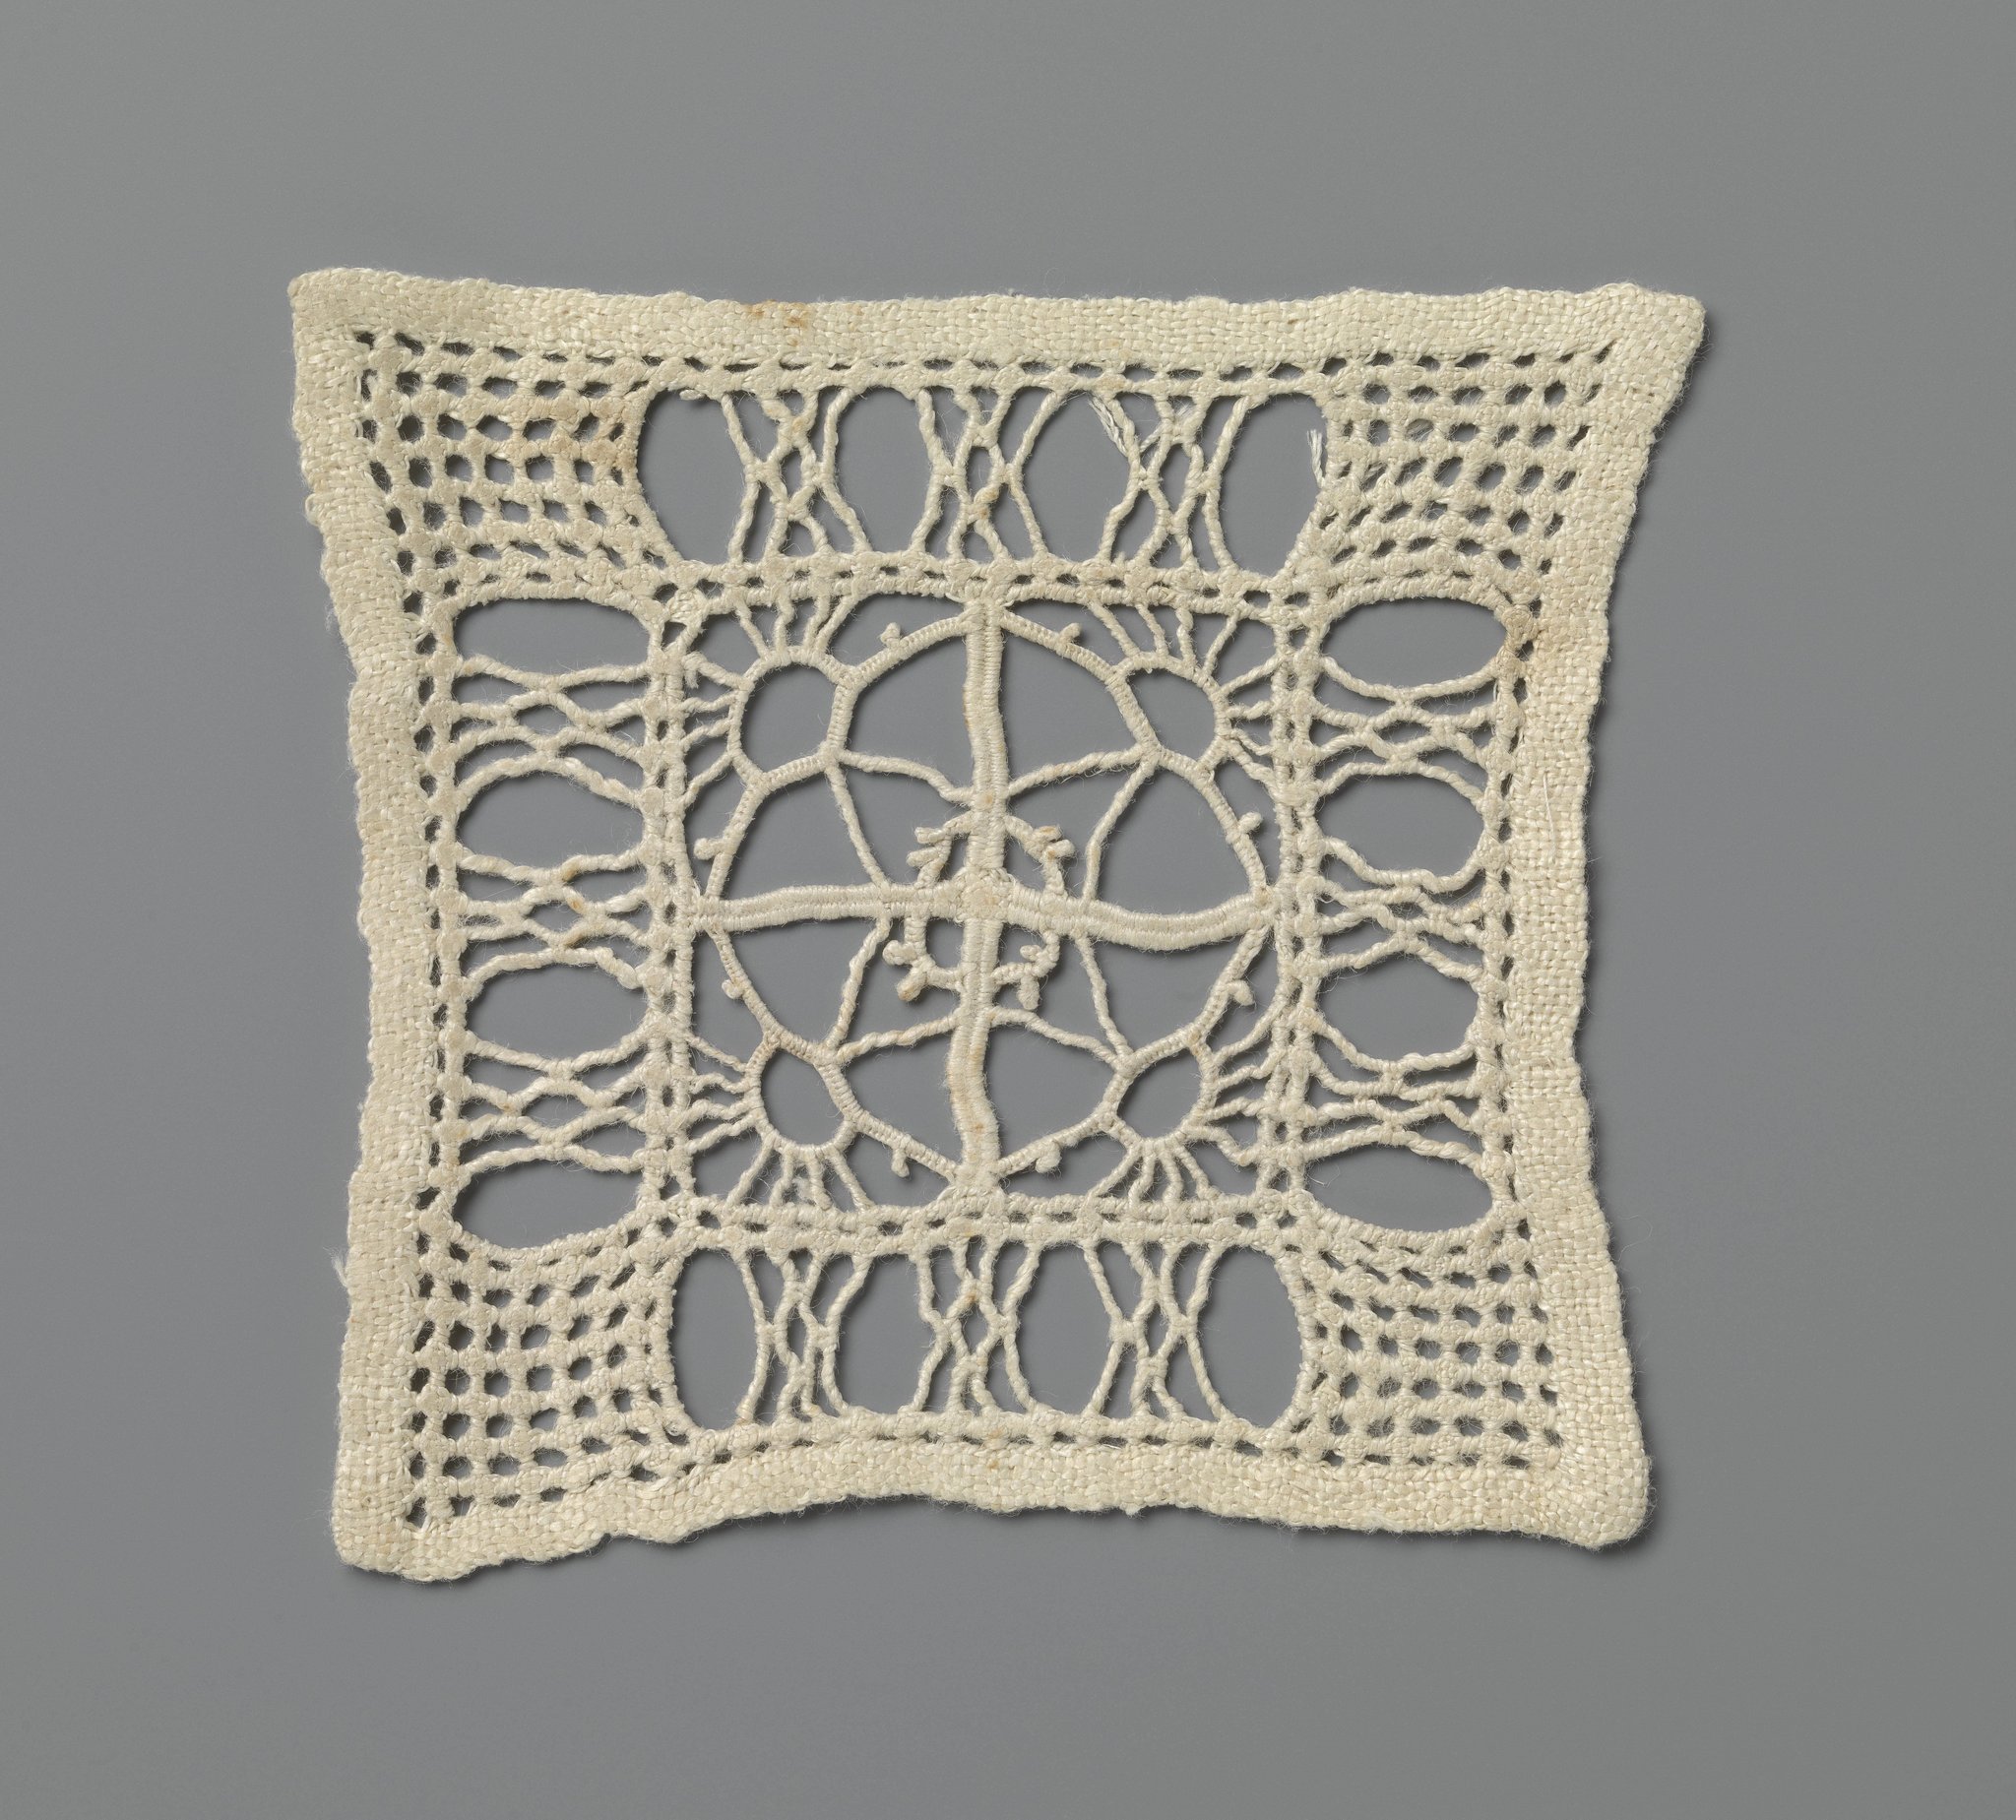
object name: mat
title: Kleedje van kantborduurwerk met opkomende zonnen langs ruitvorm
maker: Anonymous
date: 1900-1949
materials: cotton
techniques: lace embroidery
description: Vierkant kleedje van naturelkleurig kantborduurwerk, gesneden werk. Patroon met een vierkant die is opgebouwd uit vier kleine vierkanten. Elk klein vierkant is door een diagonale lijn verdeeld, met aan de buitenzijde een 'opkomende zon' en aan de binnenzijde een driehoek. Tezamen zorgt dit in het grote vierkant voor een ruitvorm met een vierpuntige ster in het midden. Om het grote vierkant aan alle zijden een rand met rechthoeken, gevuld met bundeltjes draden of met een dicht rasterwerk met opengewerkte ruitjes. Aan alle zijden een afgewerkte rand in linnenslag.